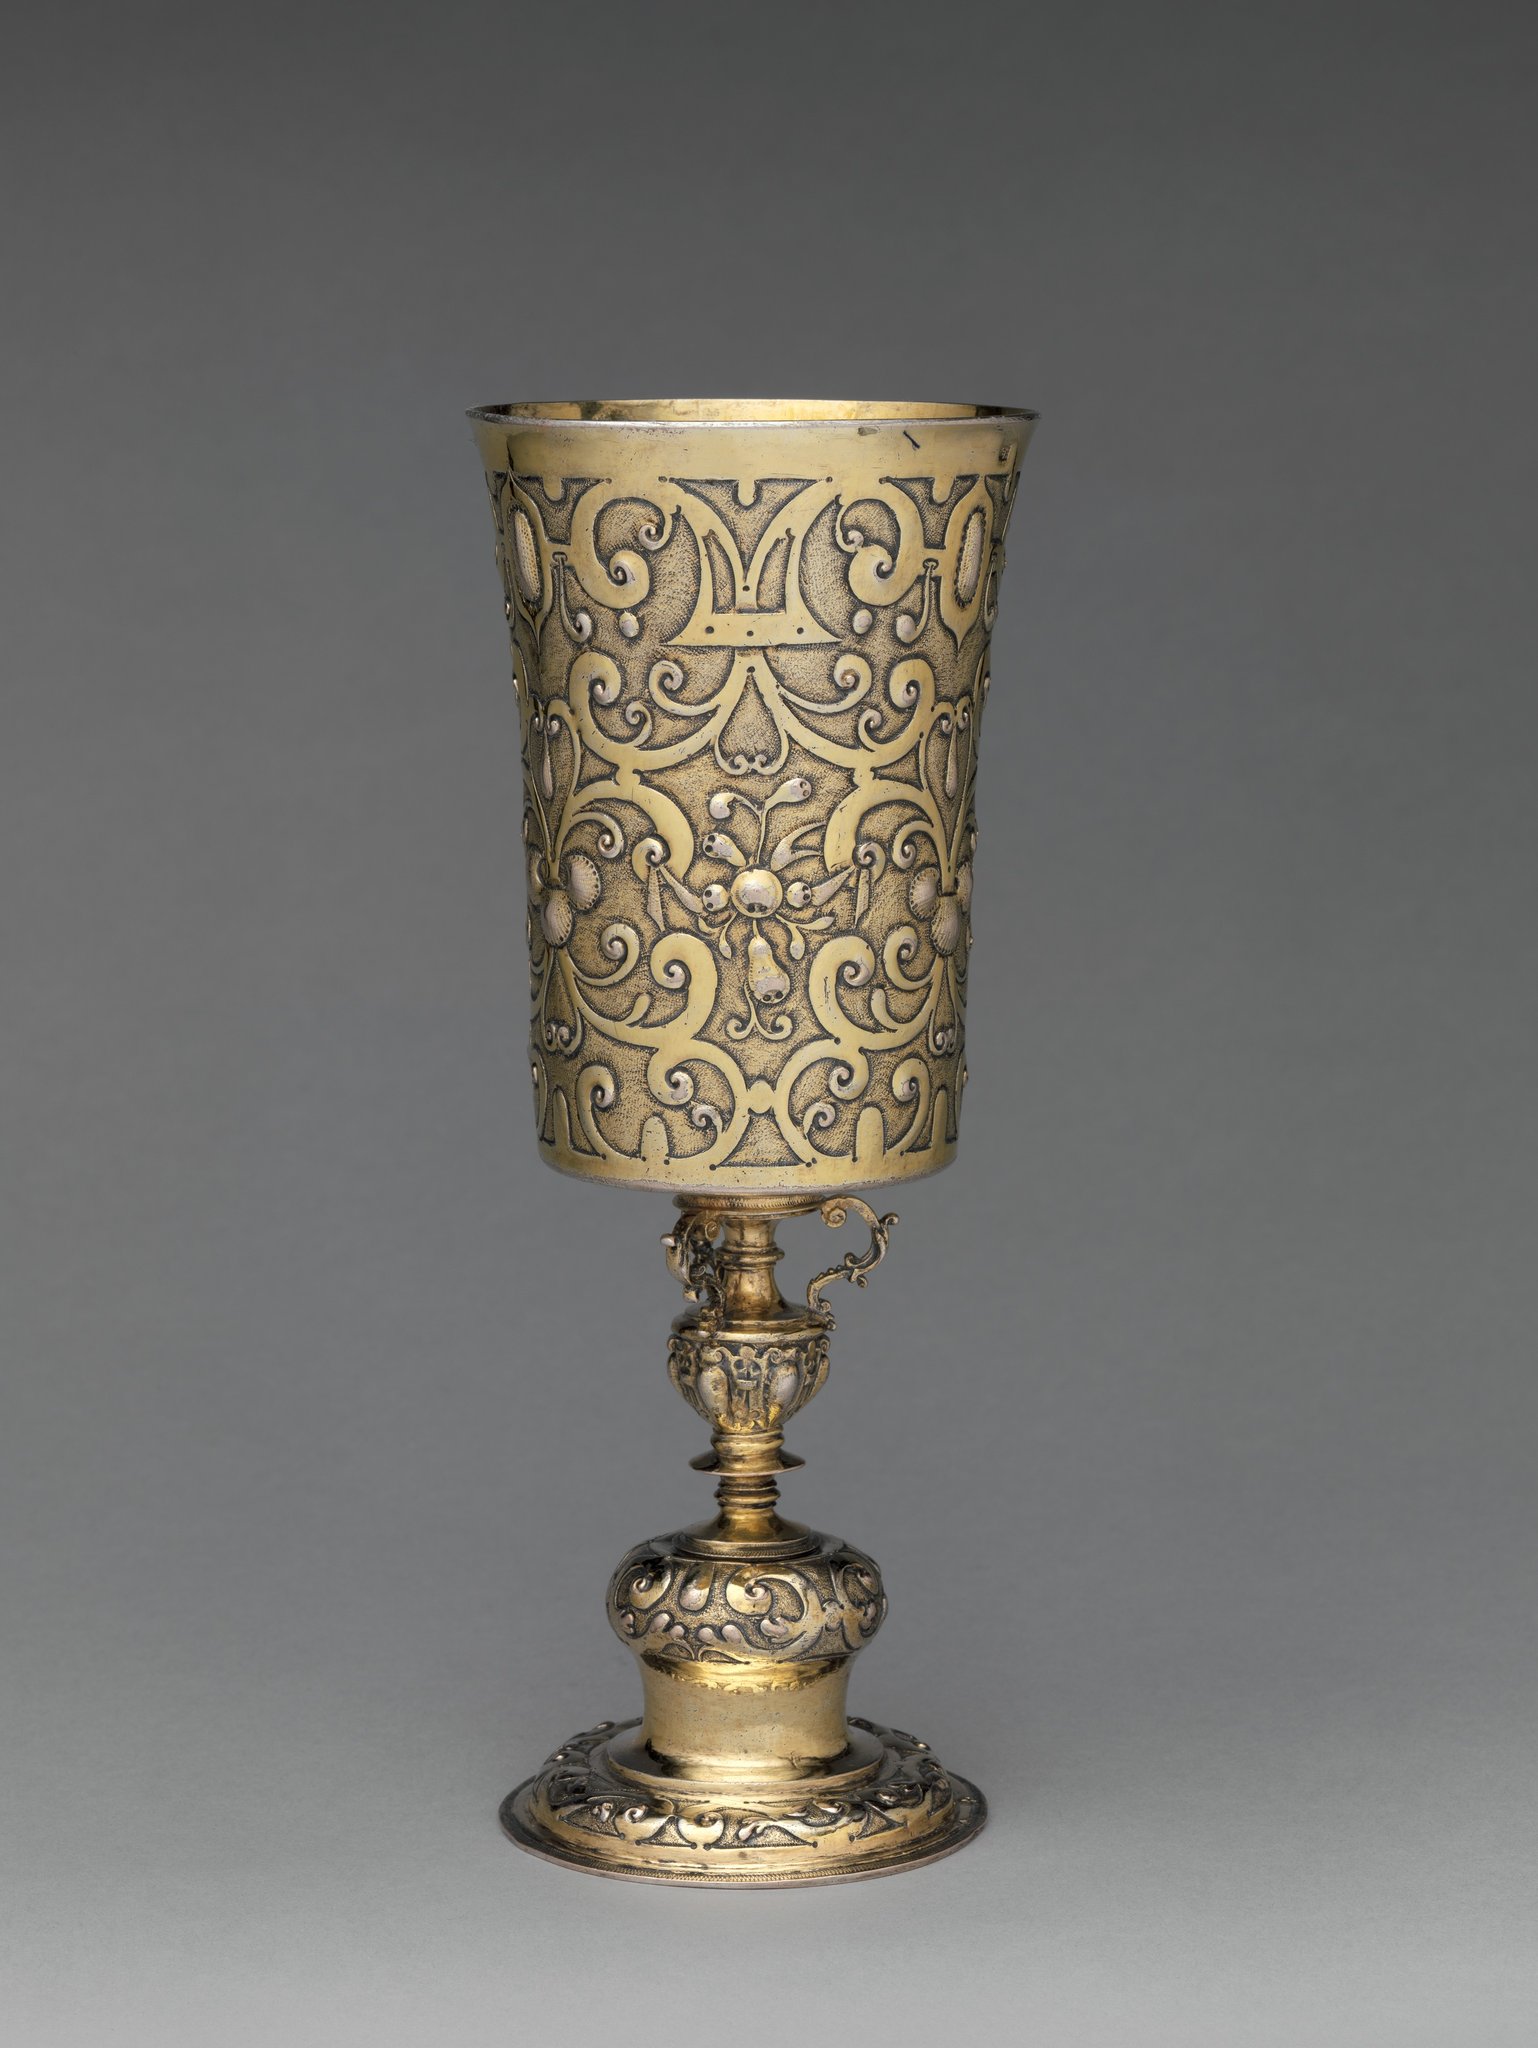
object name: standing cup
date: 1601-1633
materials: gilt silver